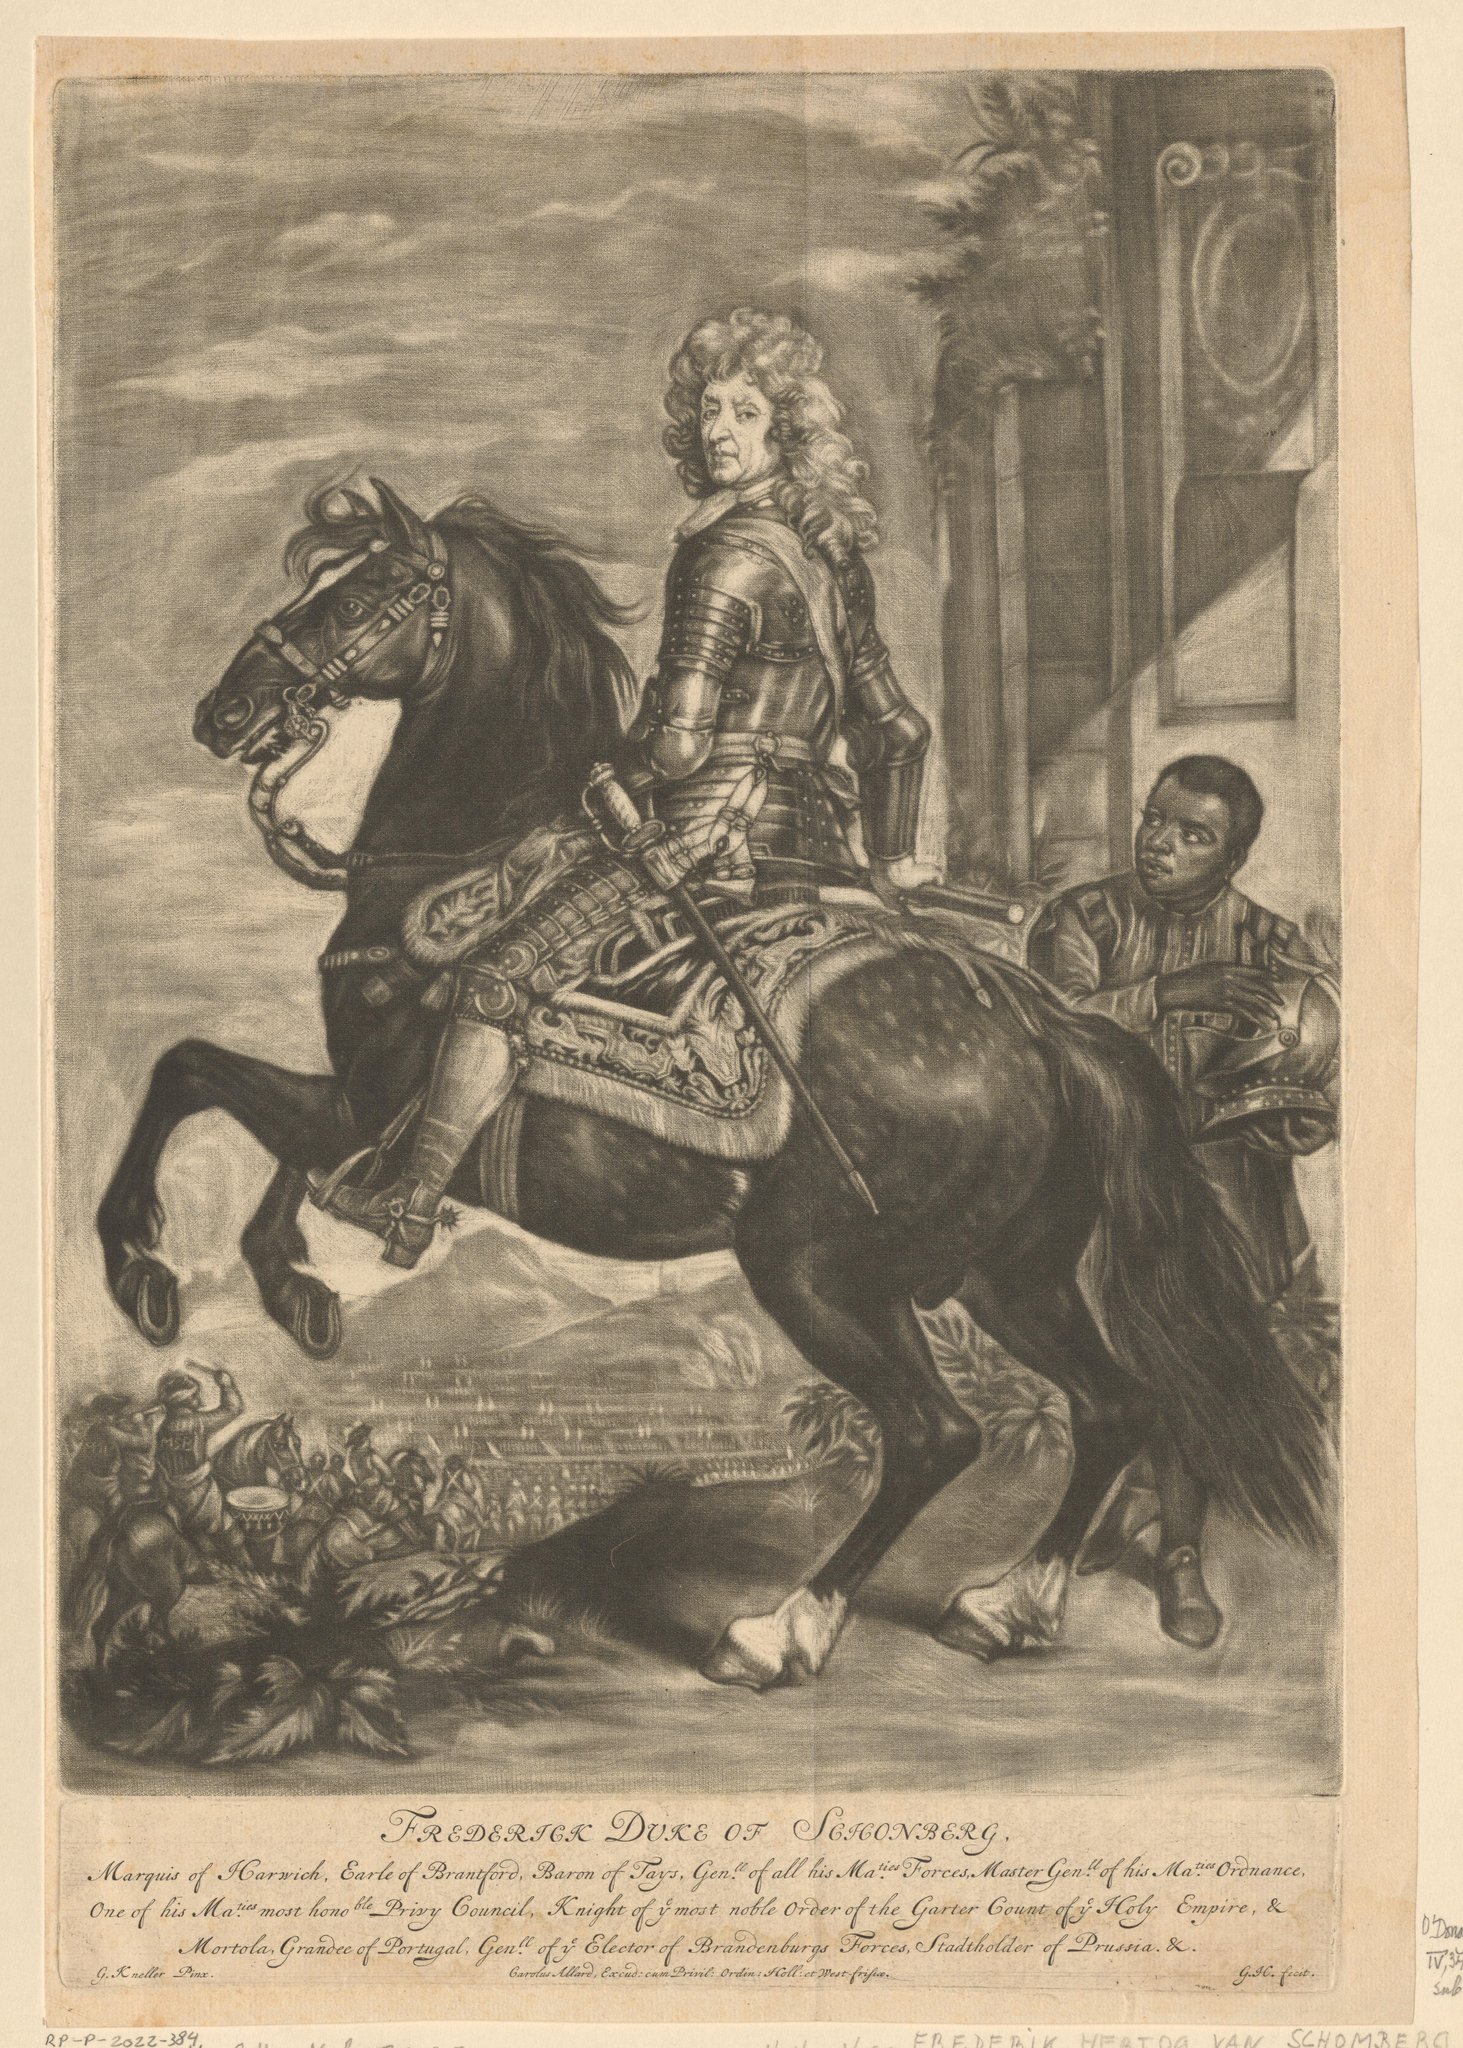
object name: print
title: Ruiterportret van Frederick Schomberg in harnas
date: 1683-1709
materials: paper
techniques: engraving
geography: amsterdam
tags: equestrian state-portrait, historical persons, battle, slavery; serfs and enslaved persons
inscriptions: monogram: ‘G.H. fecit.’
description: Rechts houdt een van oorsprong Afrikaanse jongen, vermoedelijk een tot slaaf gemaakte bediende, zijn helm vast. Op de achtergrond een slagveld. Tekst in het Engels in de ondermarge.